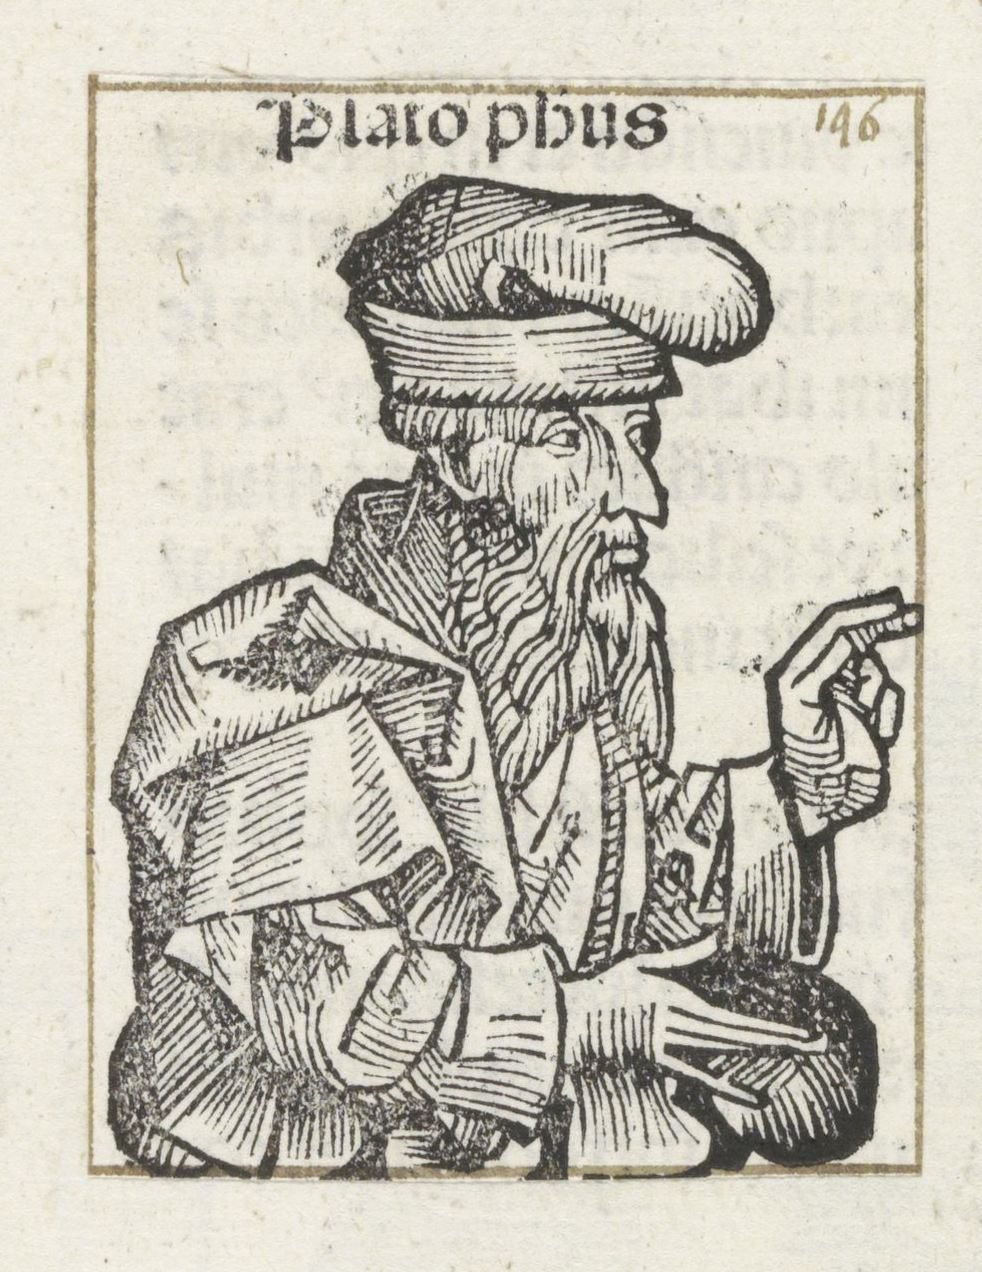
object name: print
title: Plato ph[ilosop]us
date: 1493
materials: paper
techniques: letterpress printing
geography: nuremberg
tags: male persons from classical history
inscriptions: inscription: ‘146’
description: De houtsnede wordt gebruikt als boekillustratie in de Liber Chronicarum (of Neurenbergkroniek) van Hartmann Schedel, verschenen in het Latijn en Duits in 1493. Zie de Latijnse uitgave, folio 73v.